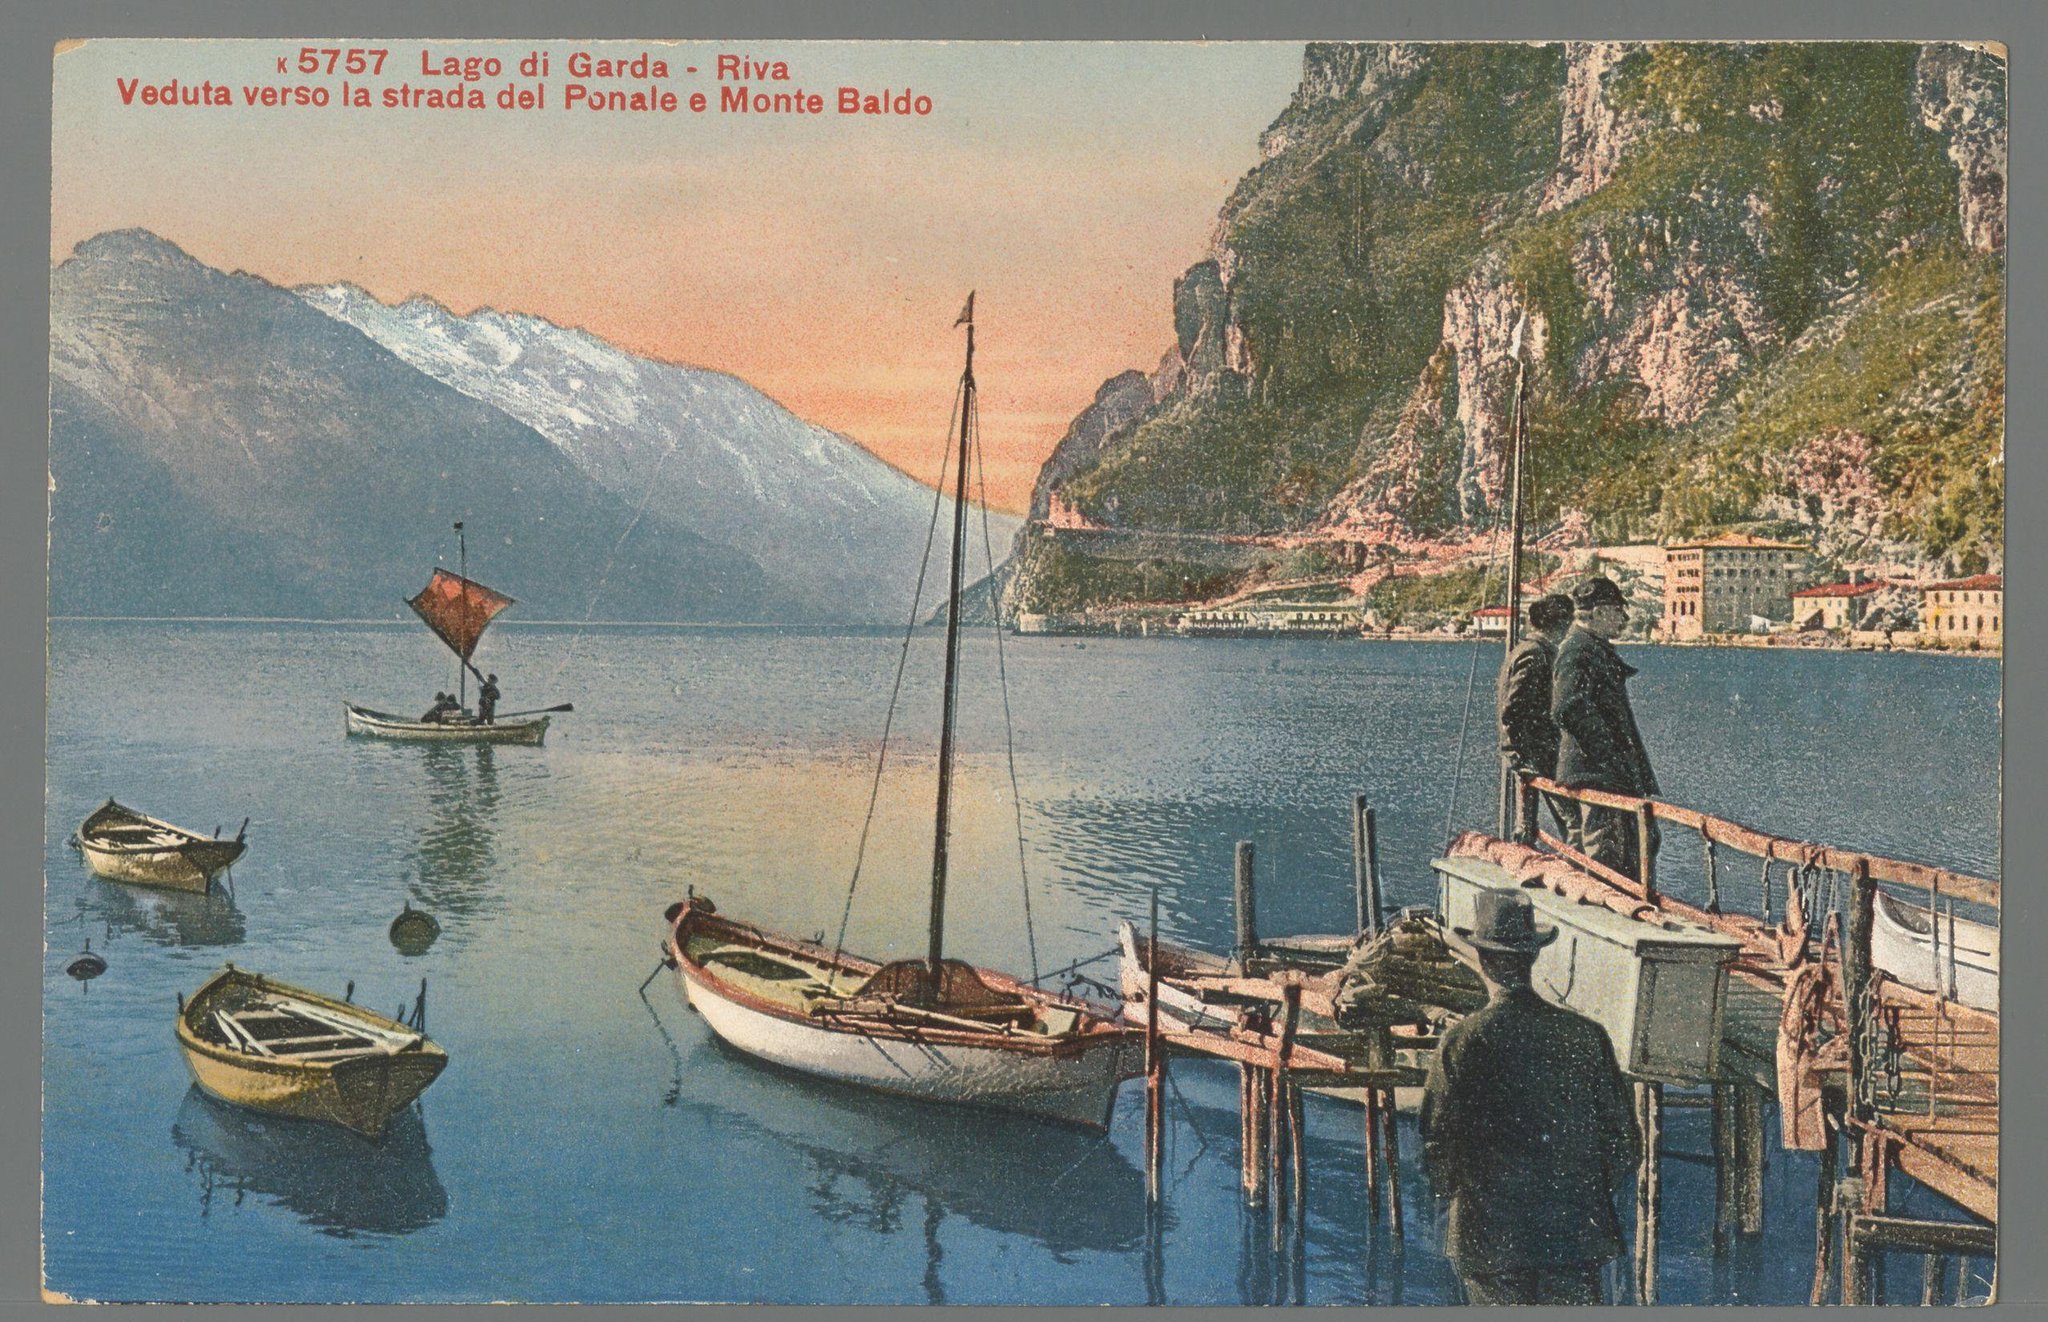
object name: photomechanical print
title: Lago di Garda. Riva. Veduta verso la strada del Ponale e Monte Baldo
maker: Anonymous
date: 1905-1930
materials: cardboard, photographic process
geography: zurich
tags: ships (in general), lake, mountains